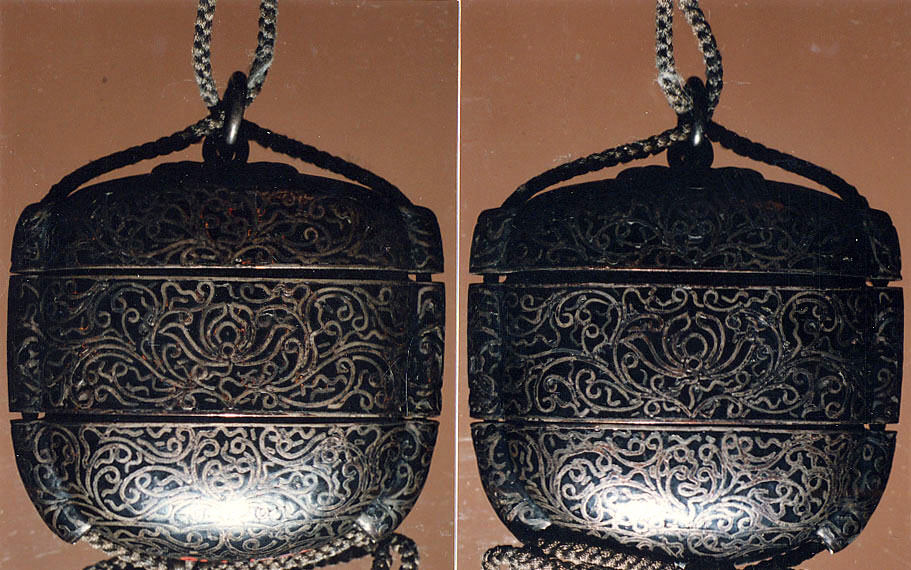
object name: inrō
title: Case (Inrō)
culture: japanese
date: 1701-1900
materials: metal, metal thread, silver, wood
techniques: lacquer